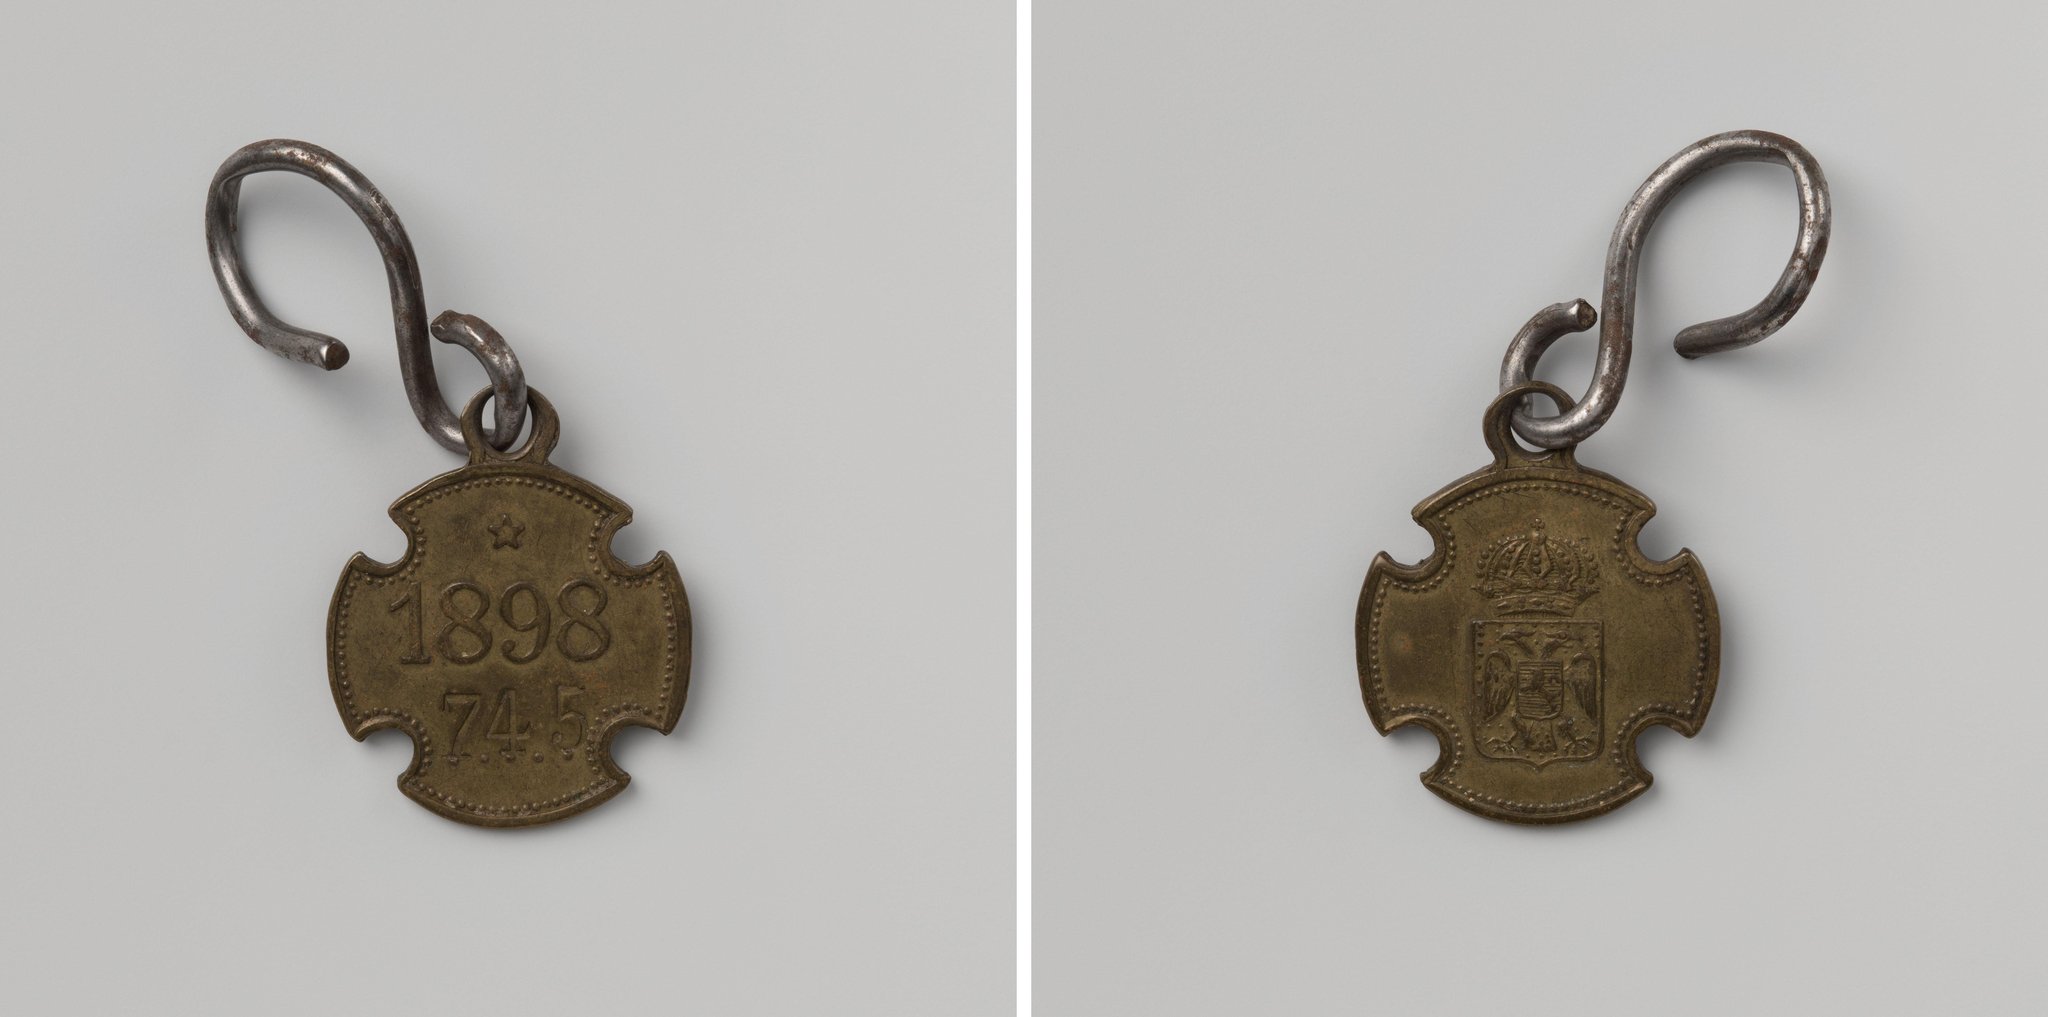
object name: tax token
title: Loodje met no. 745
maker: Anonymous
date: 1898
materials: brass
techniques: striking